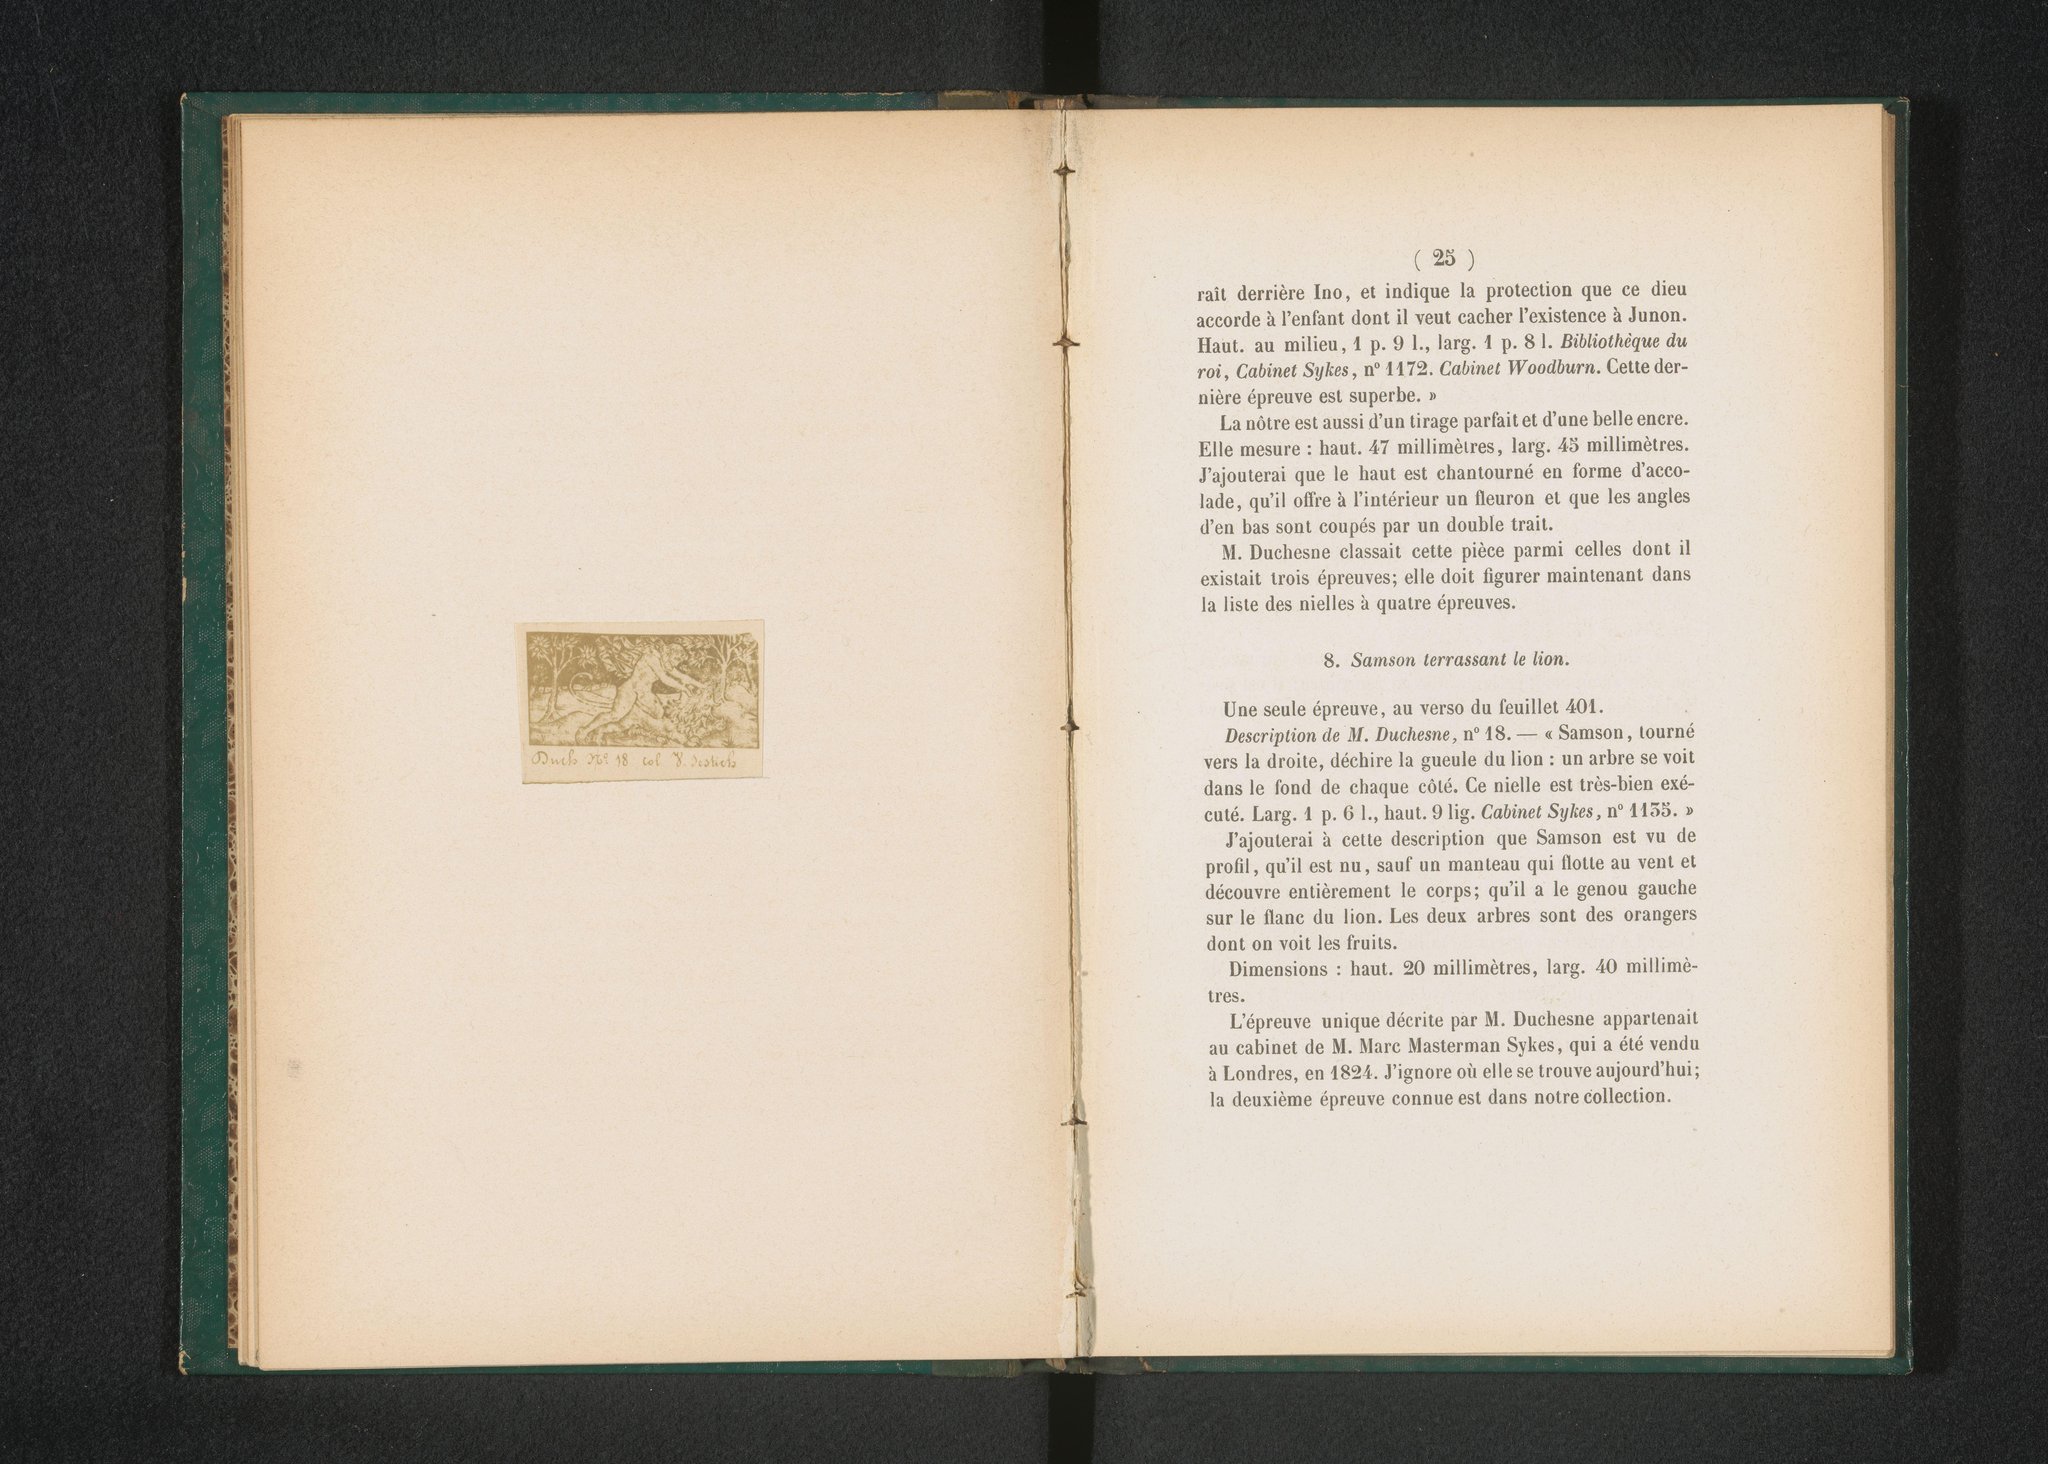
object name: page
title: Fotoreproductie van een prent van Samson die een leeuw doormidden scheurt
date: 1852-1857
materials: photographic support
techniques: salted paper print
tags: samson kills the lion with his bare hands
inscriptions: inscription: ‘Duch No 18. col. V. Sestich’